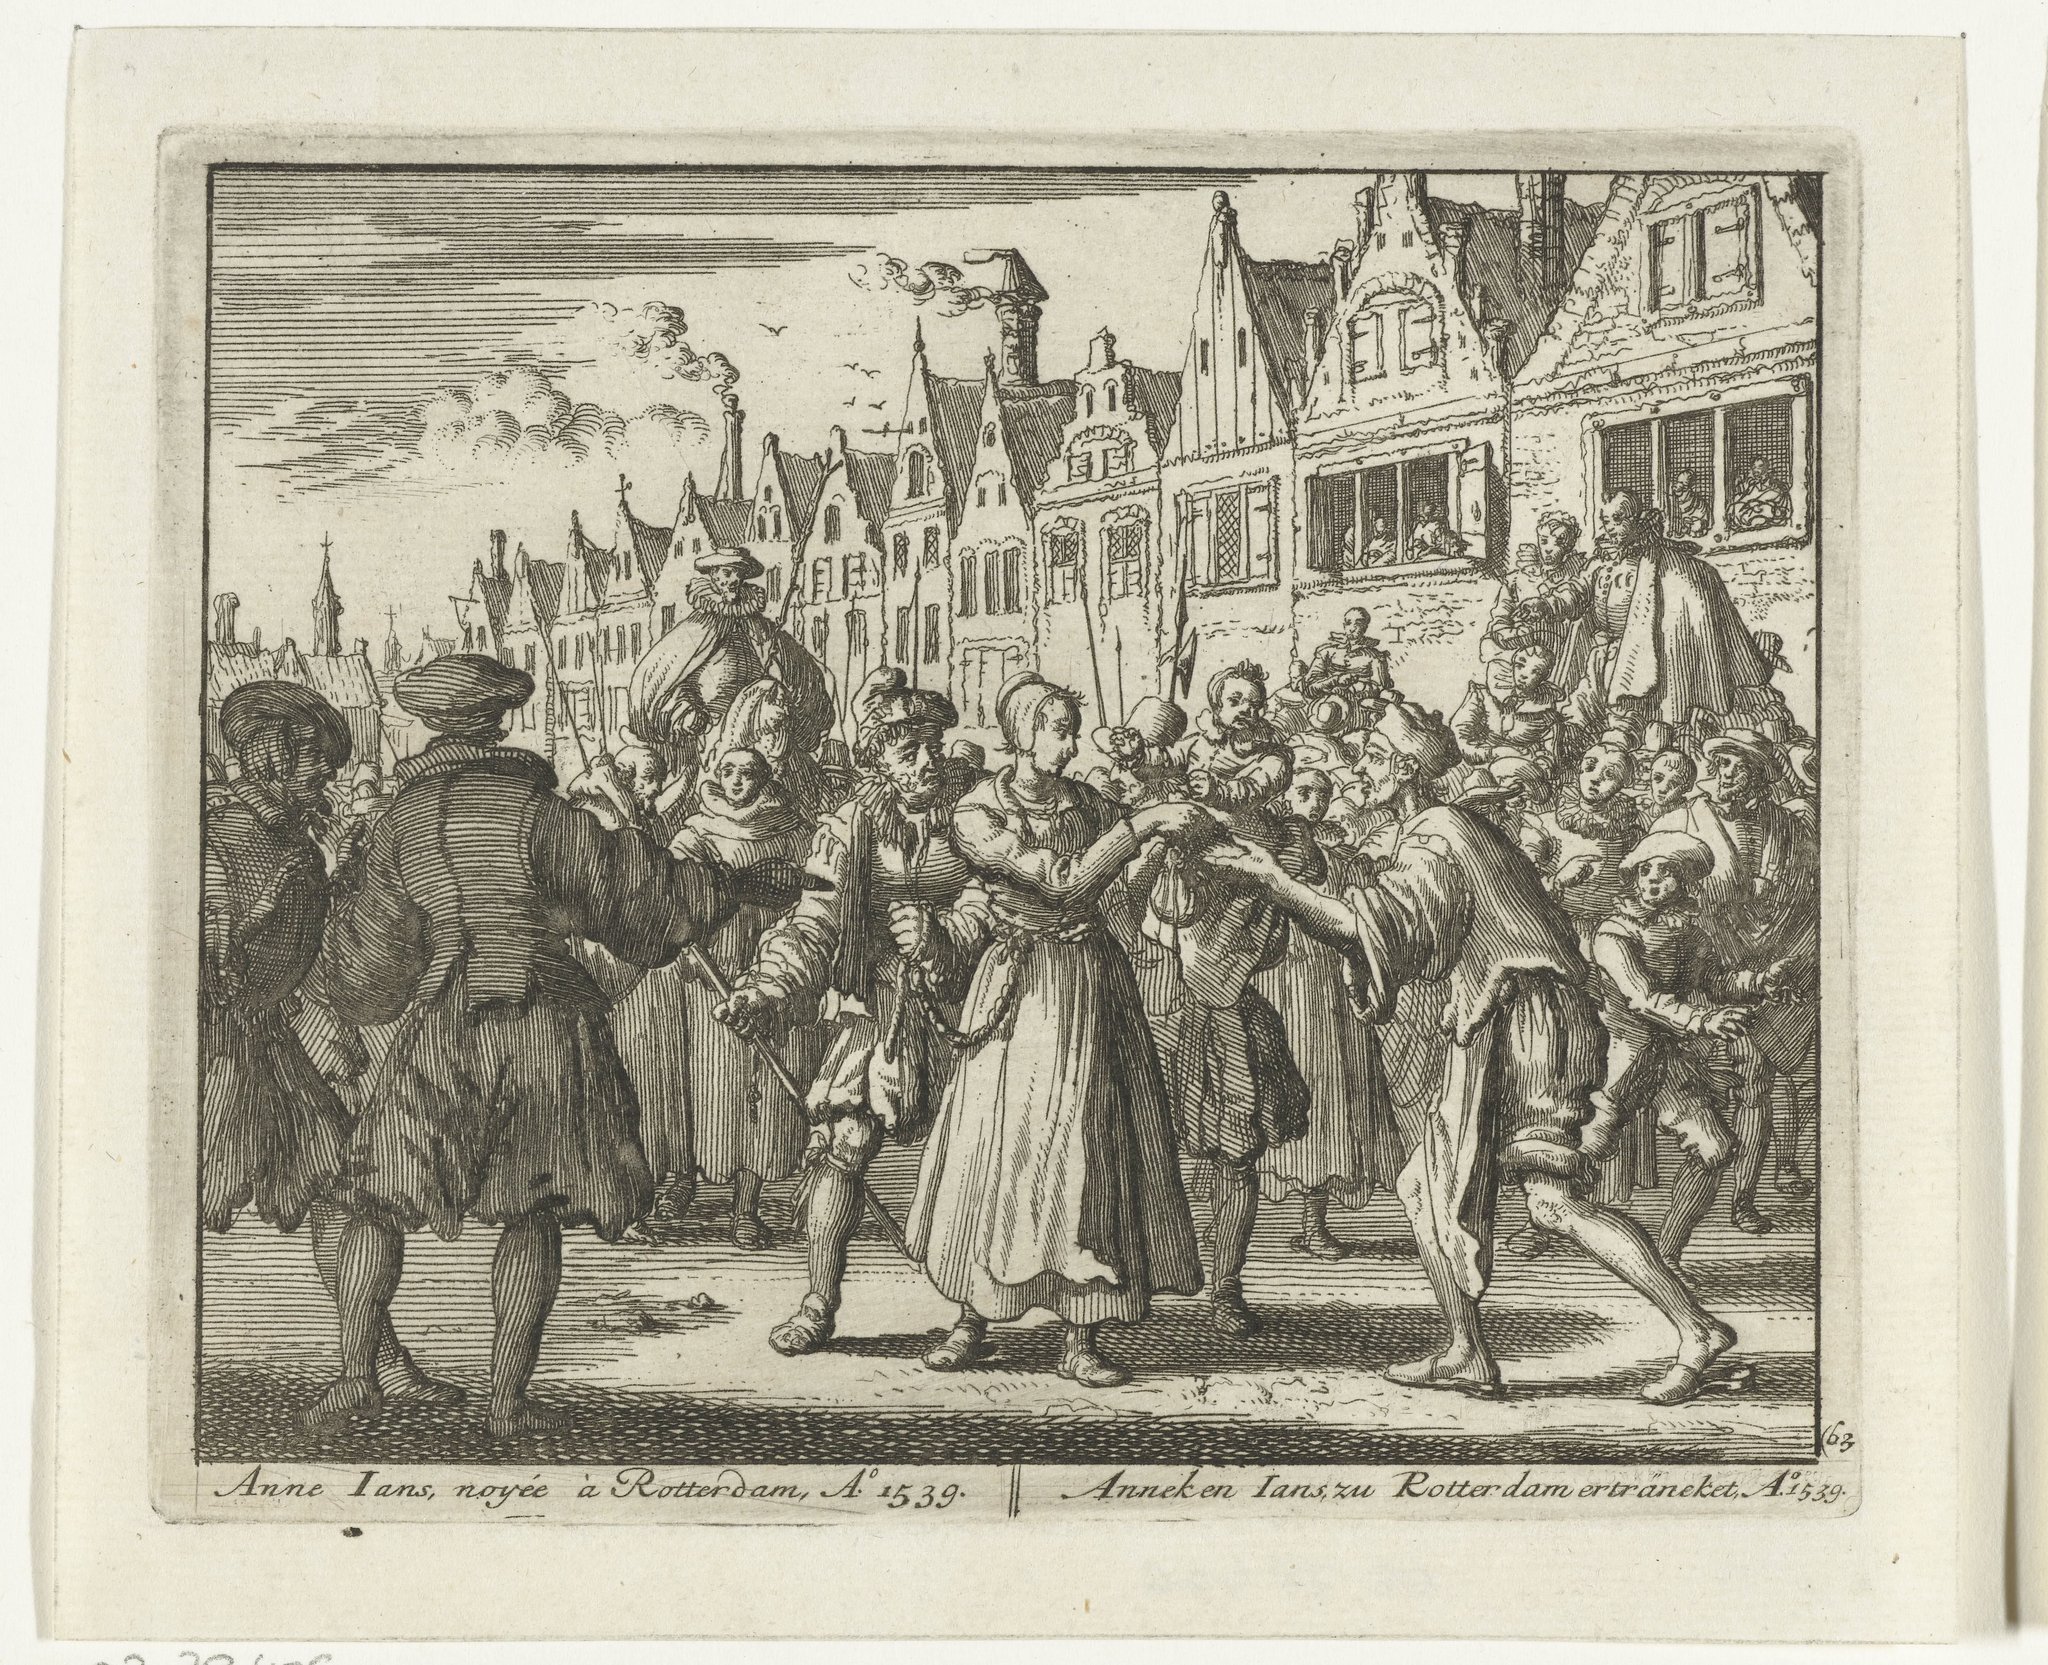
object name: print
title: Anne Ians noyée à Rotterdam, Ao. 1539 / Anneken Ians zu Rotterdam erträneket, Ao. 1550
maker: jan luyken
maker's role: draughtsman, print maker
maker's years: 1649-1712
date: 1683-1685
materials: paper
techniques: etching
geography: northern netherlands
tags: persecution of heretics, rotterdam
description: De prenten in deze tweede staat gebruikt als illustratie voor: Theatre des martyrs, depuis la mort de J. Christ jusqu'à present (...). = Schau-buhne der Martyrer, P. van der Aa, Leiden ca. 1715, nr. 63. De prenten zijn oorspronkelijk vervaardigd voor en eerst gebruikt in: T.J. van Bragt, Het bloedig tooneel, of Martelaers spiegel der doops-gesinde of weereloose christenen, 1685.